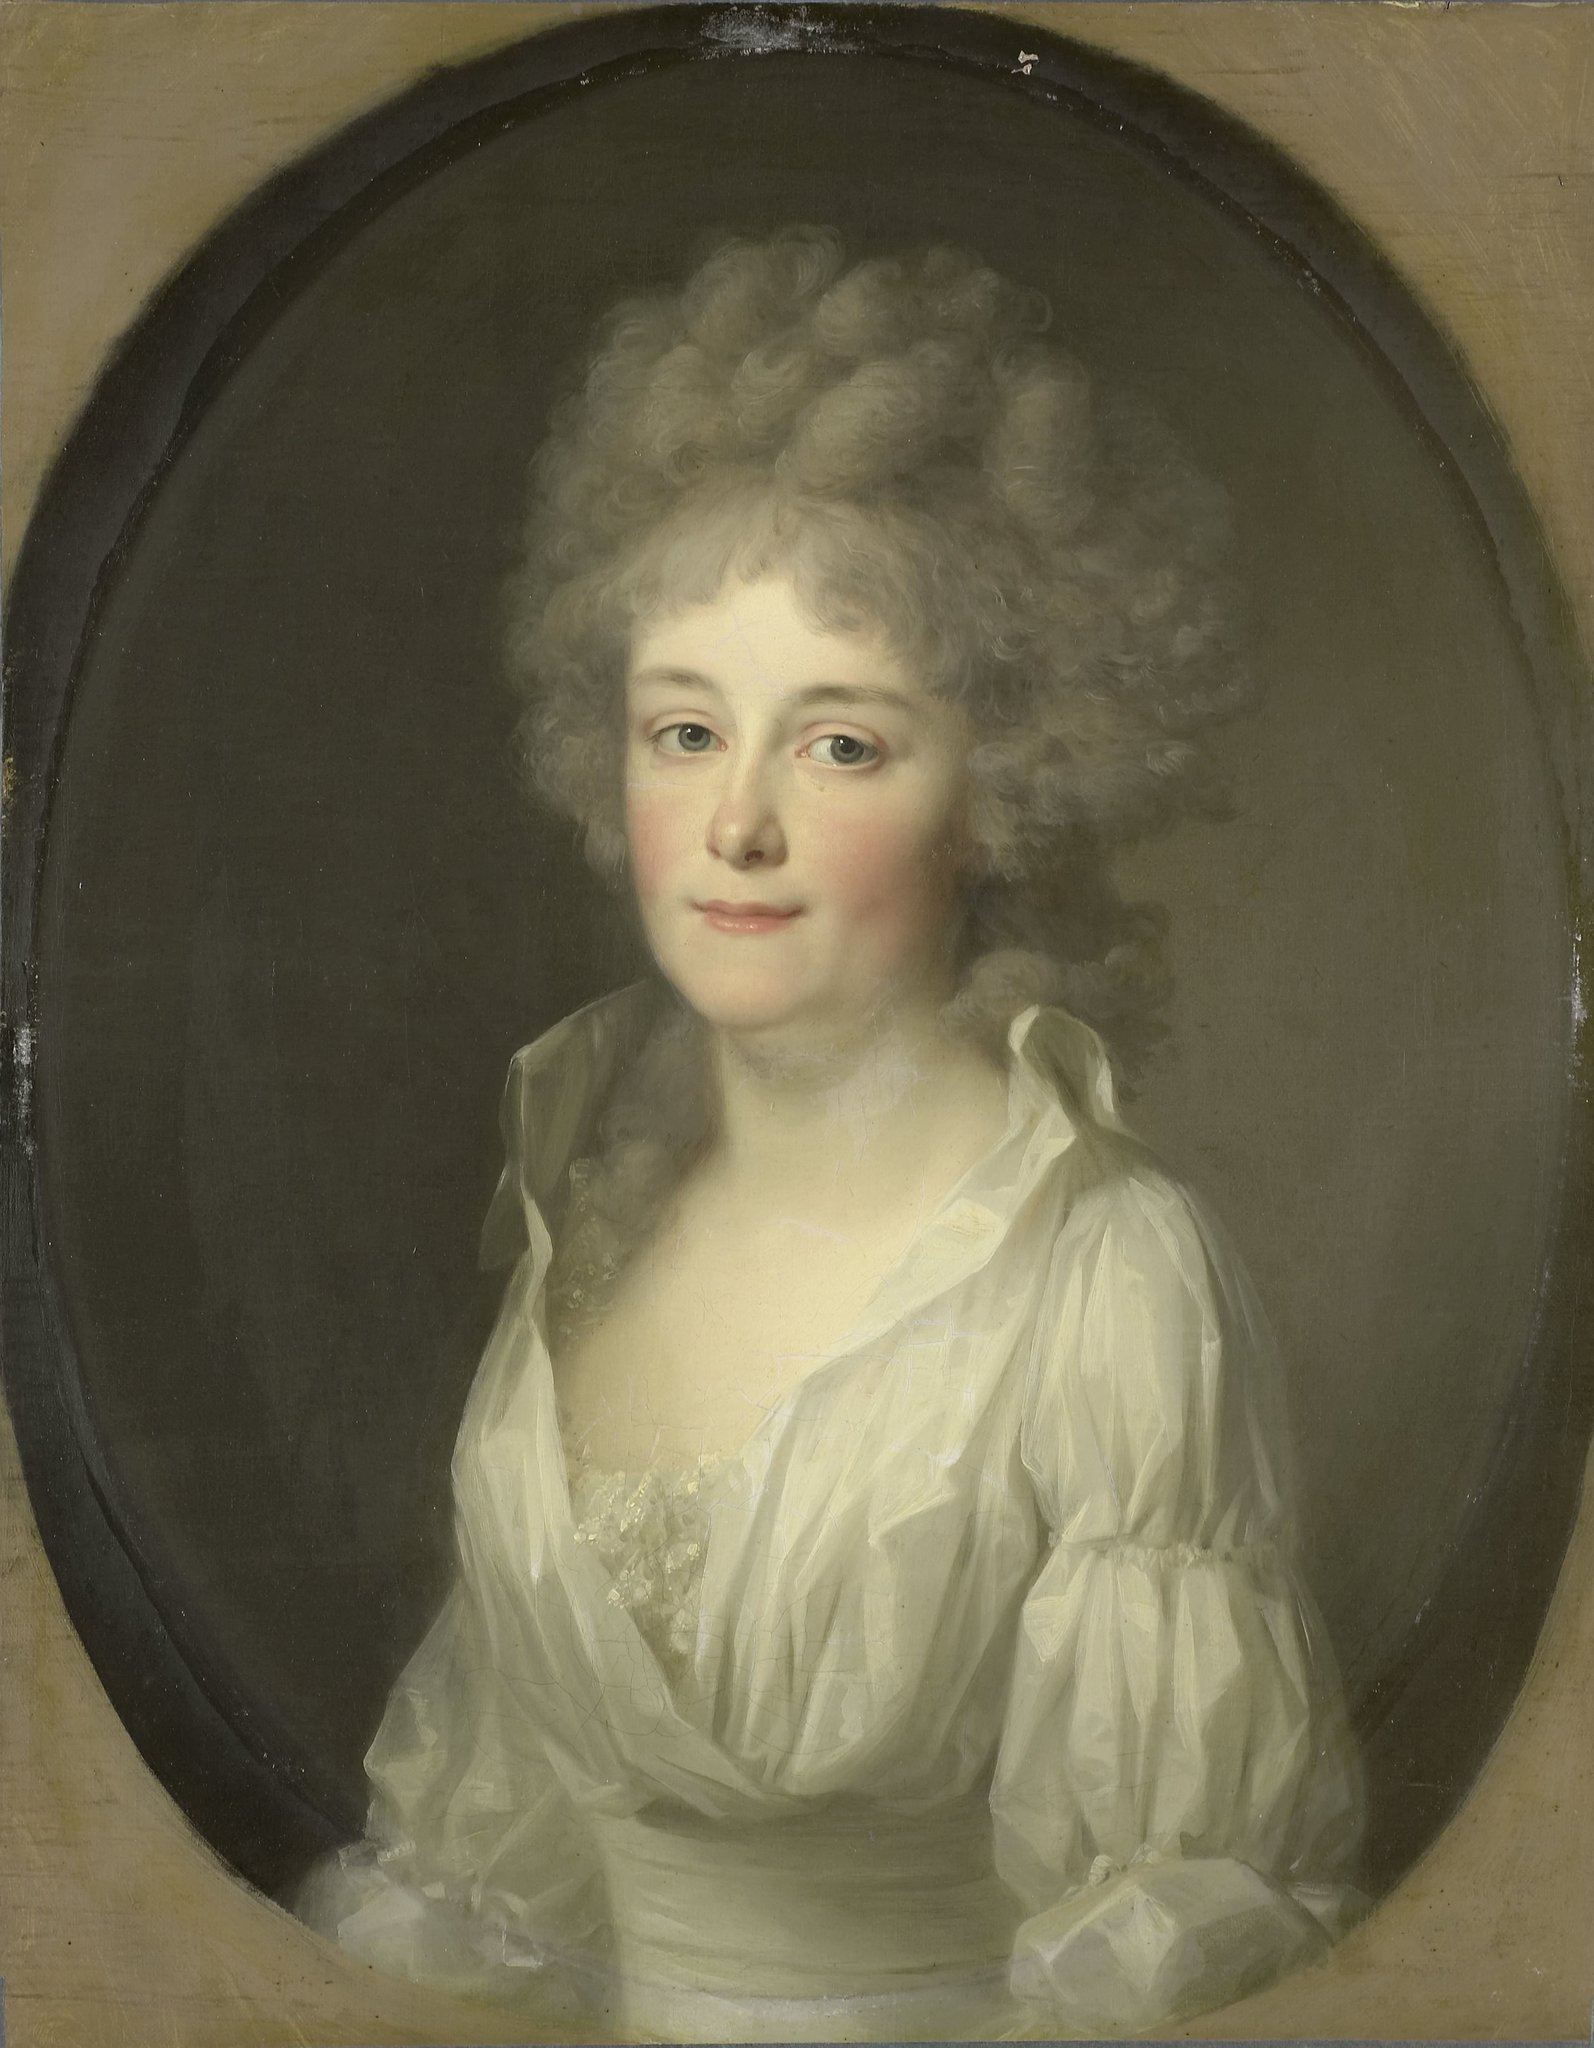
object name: painting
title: Portrait of Johanna Ferdinanda van Collen, Wife of Salomon Rendorp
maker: johann friedrich august tischbein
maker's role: painter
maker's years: 1750-1812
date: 1793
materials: canvas, oil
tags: amsterdam, historical persons - bb - woman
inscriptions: inscription: ‘Johanna Ferdinanda Rendorp Anno 1793’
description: Portret van Johanna Ferdinanda van Collen (1774-1833), echtgenote van Salomon Rendorp. Buste in ovaal, naar links gewend. Pendant van SK-A-2414.